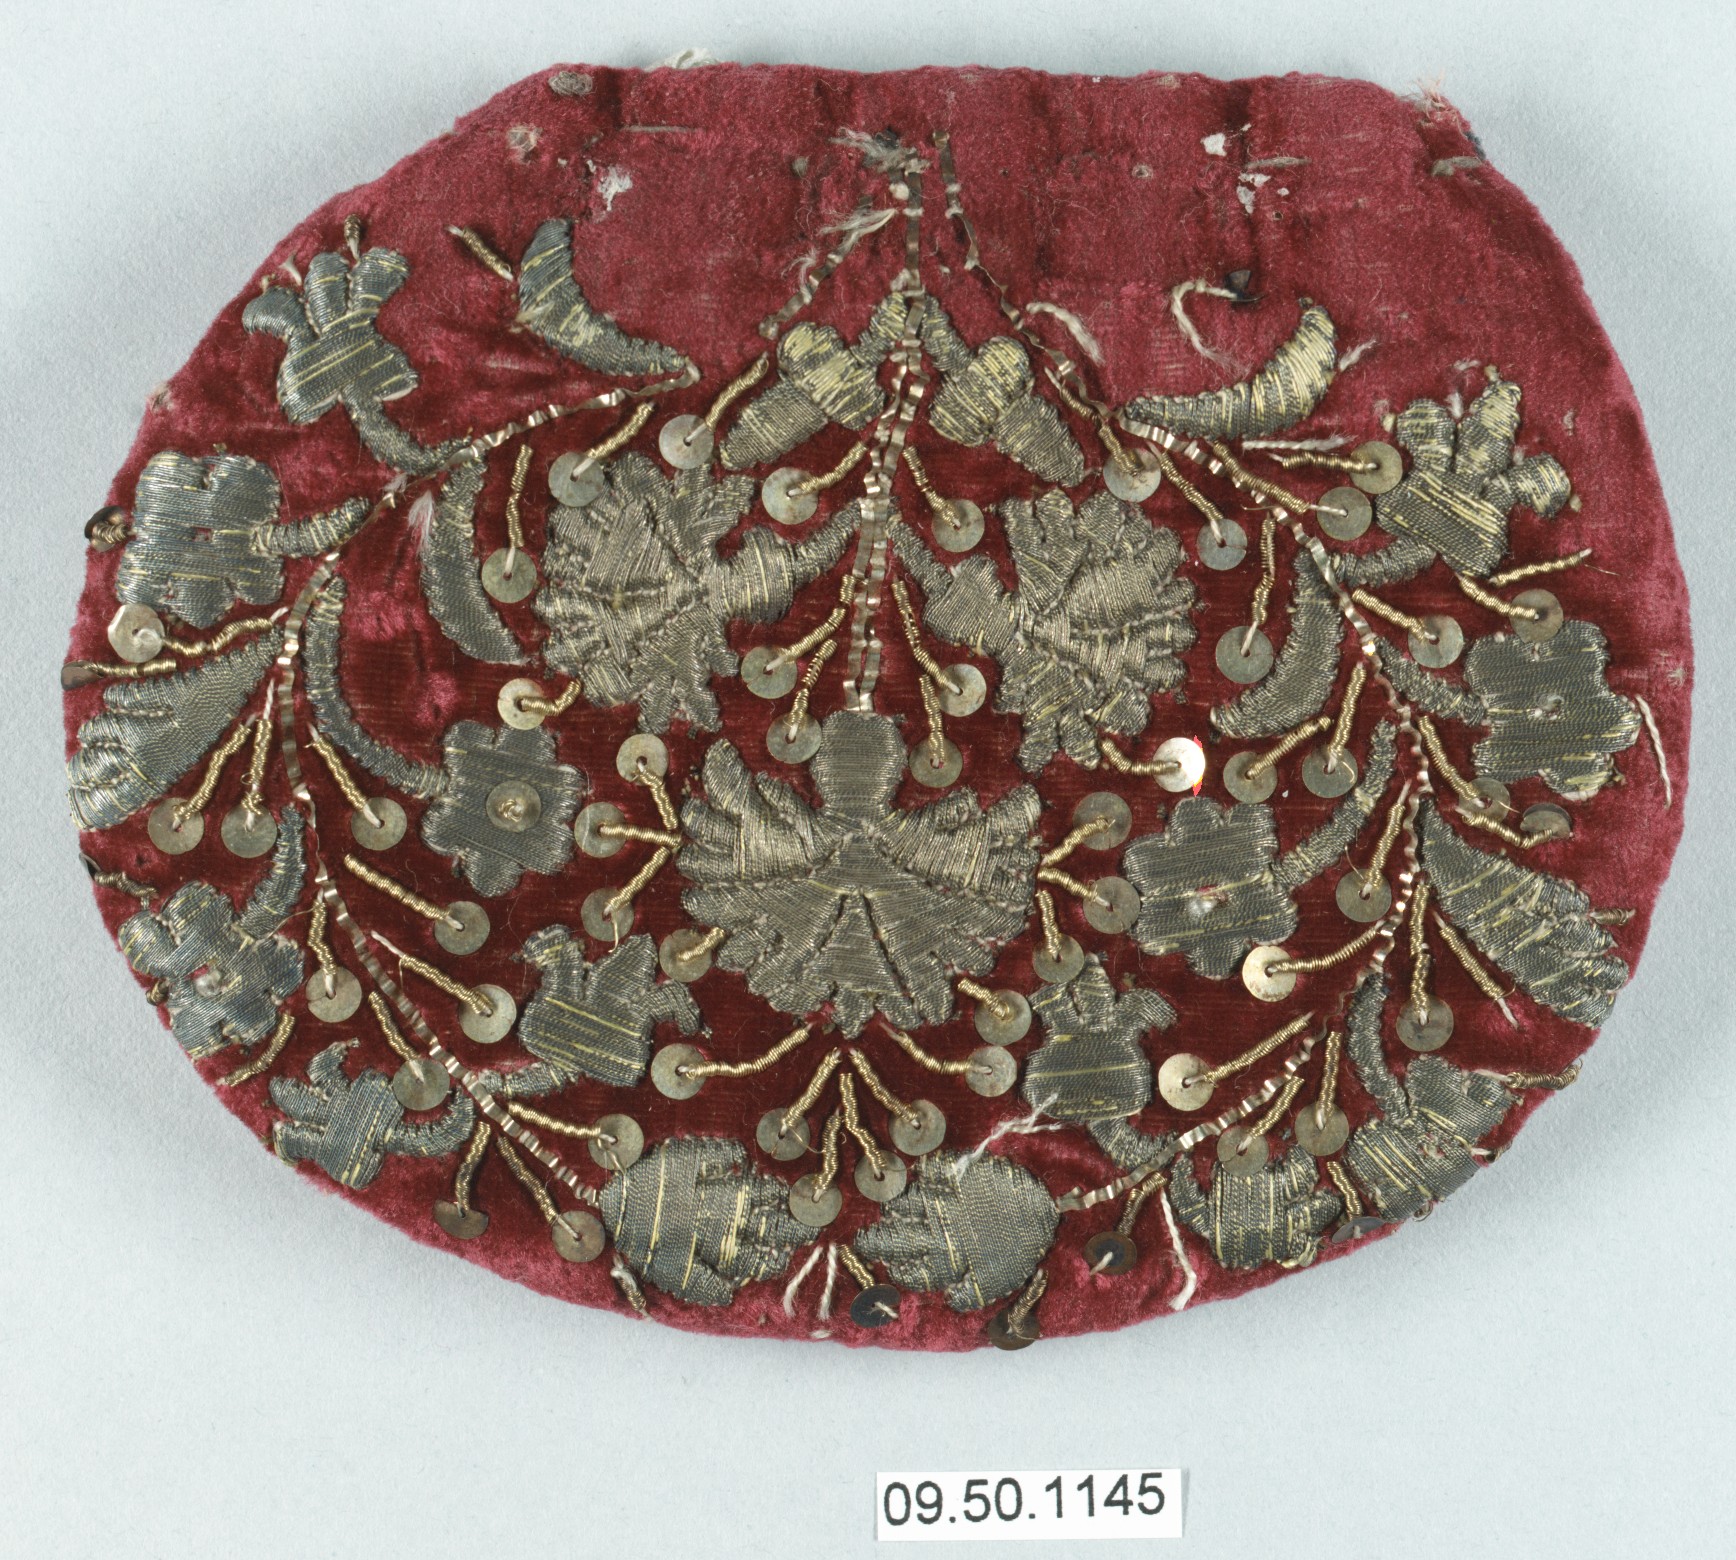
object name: cap crown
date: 1701-1800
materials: metal thread, velvet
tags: flowers